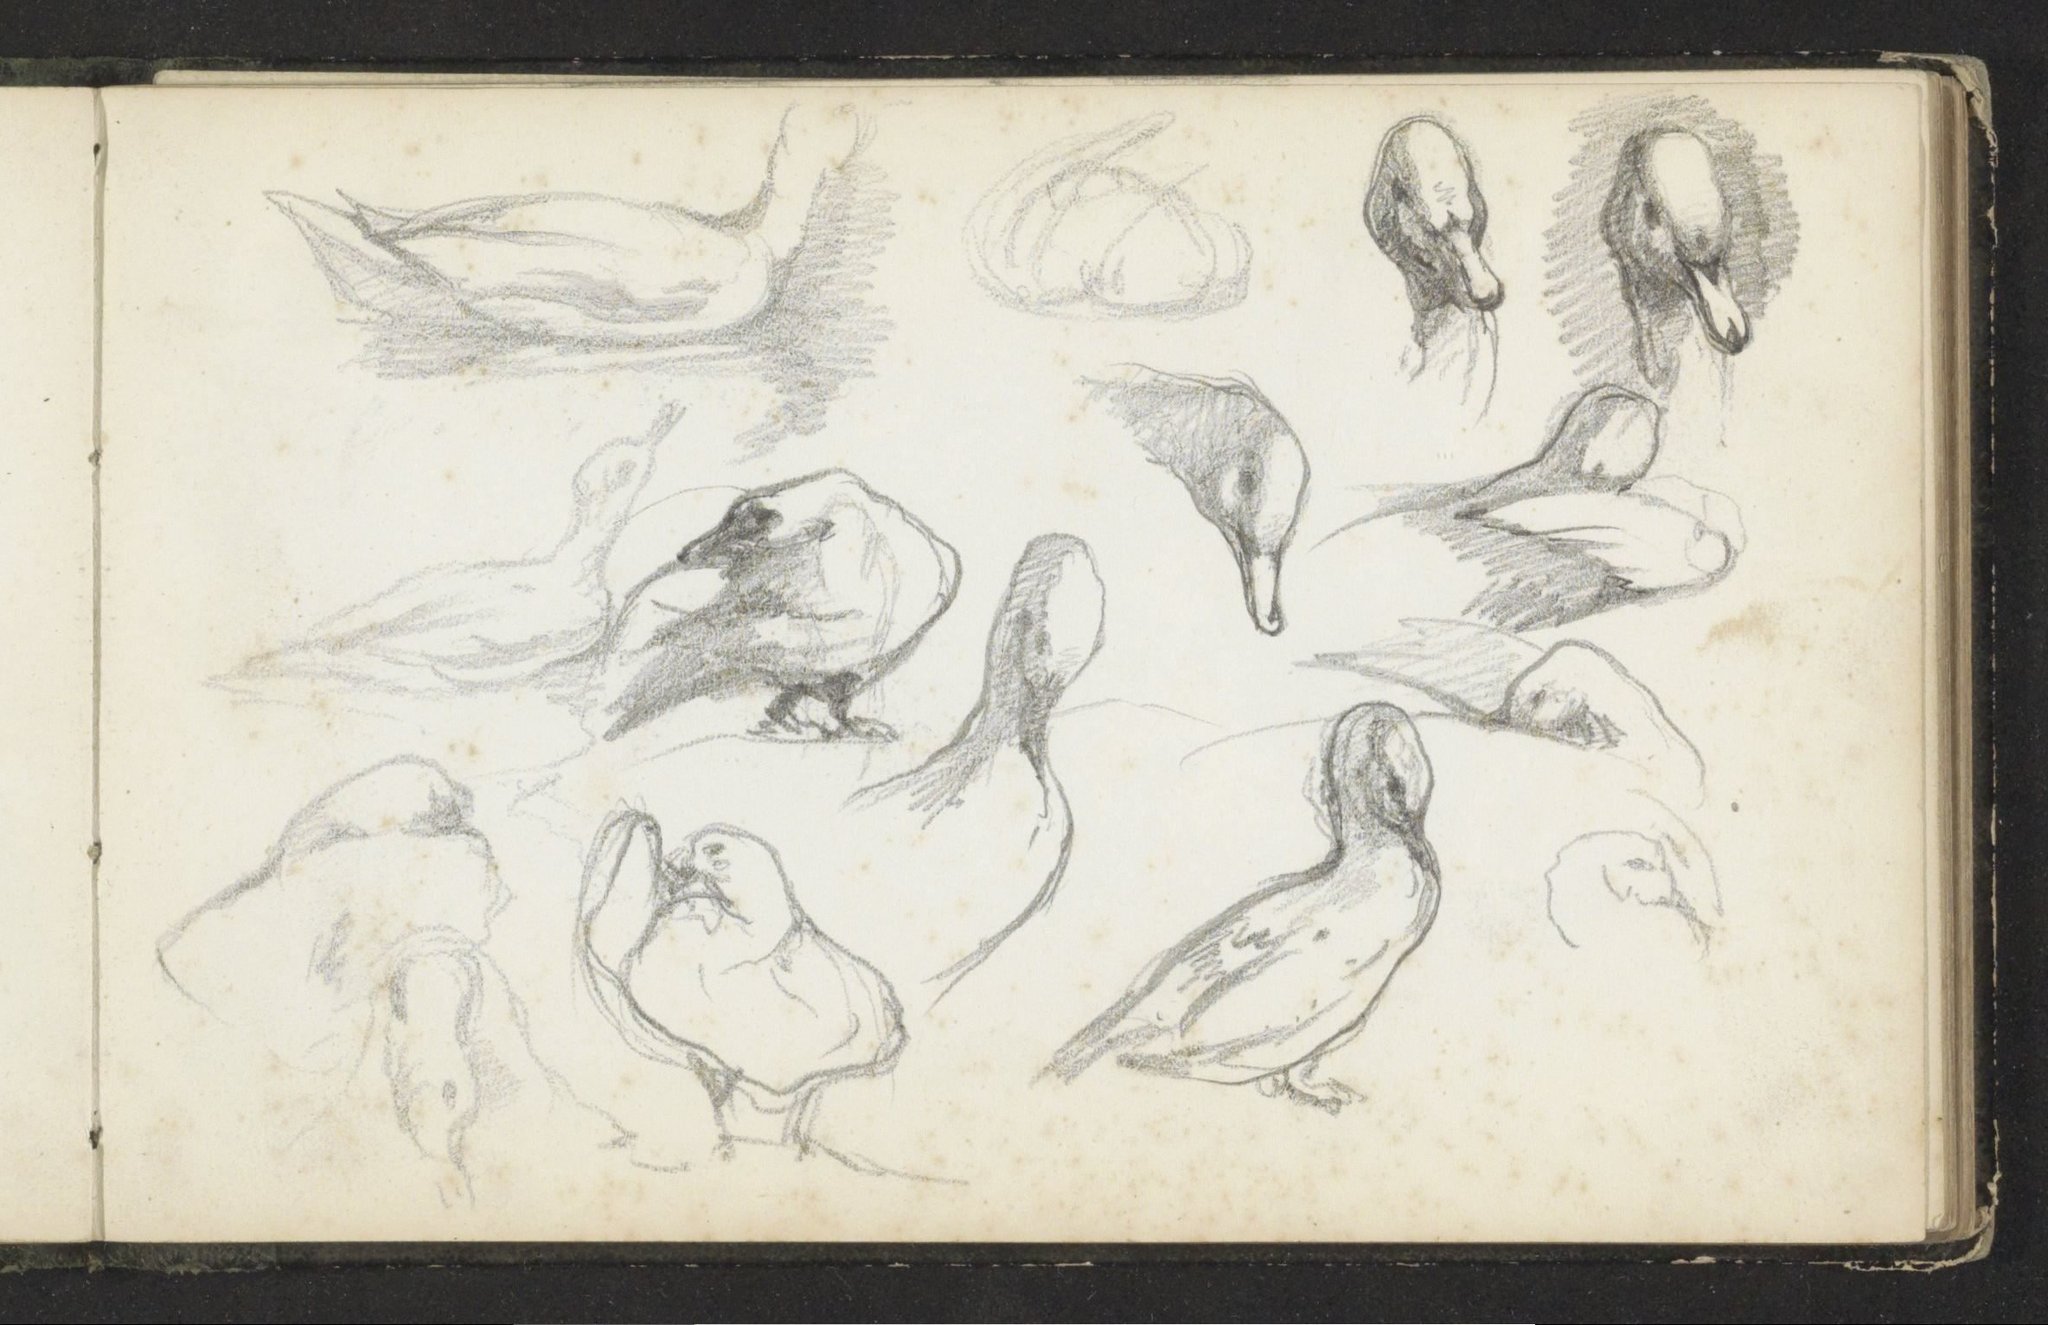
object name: sketchbook leaf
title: Eenden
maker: maria vos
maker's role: draughtsman, painter, print maker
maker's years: 1824-1906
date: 1856-1870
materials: paper, pencil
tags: water-birds: duck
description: Blad 16 recto uit een schetsboek met 39 bladen.